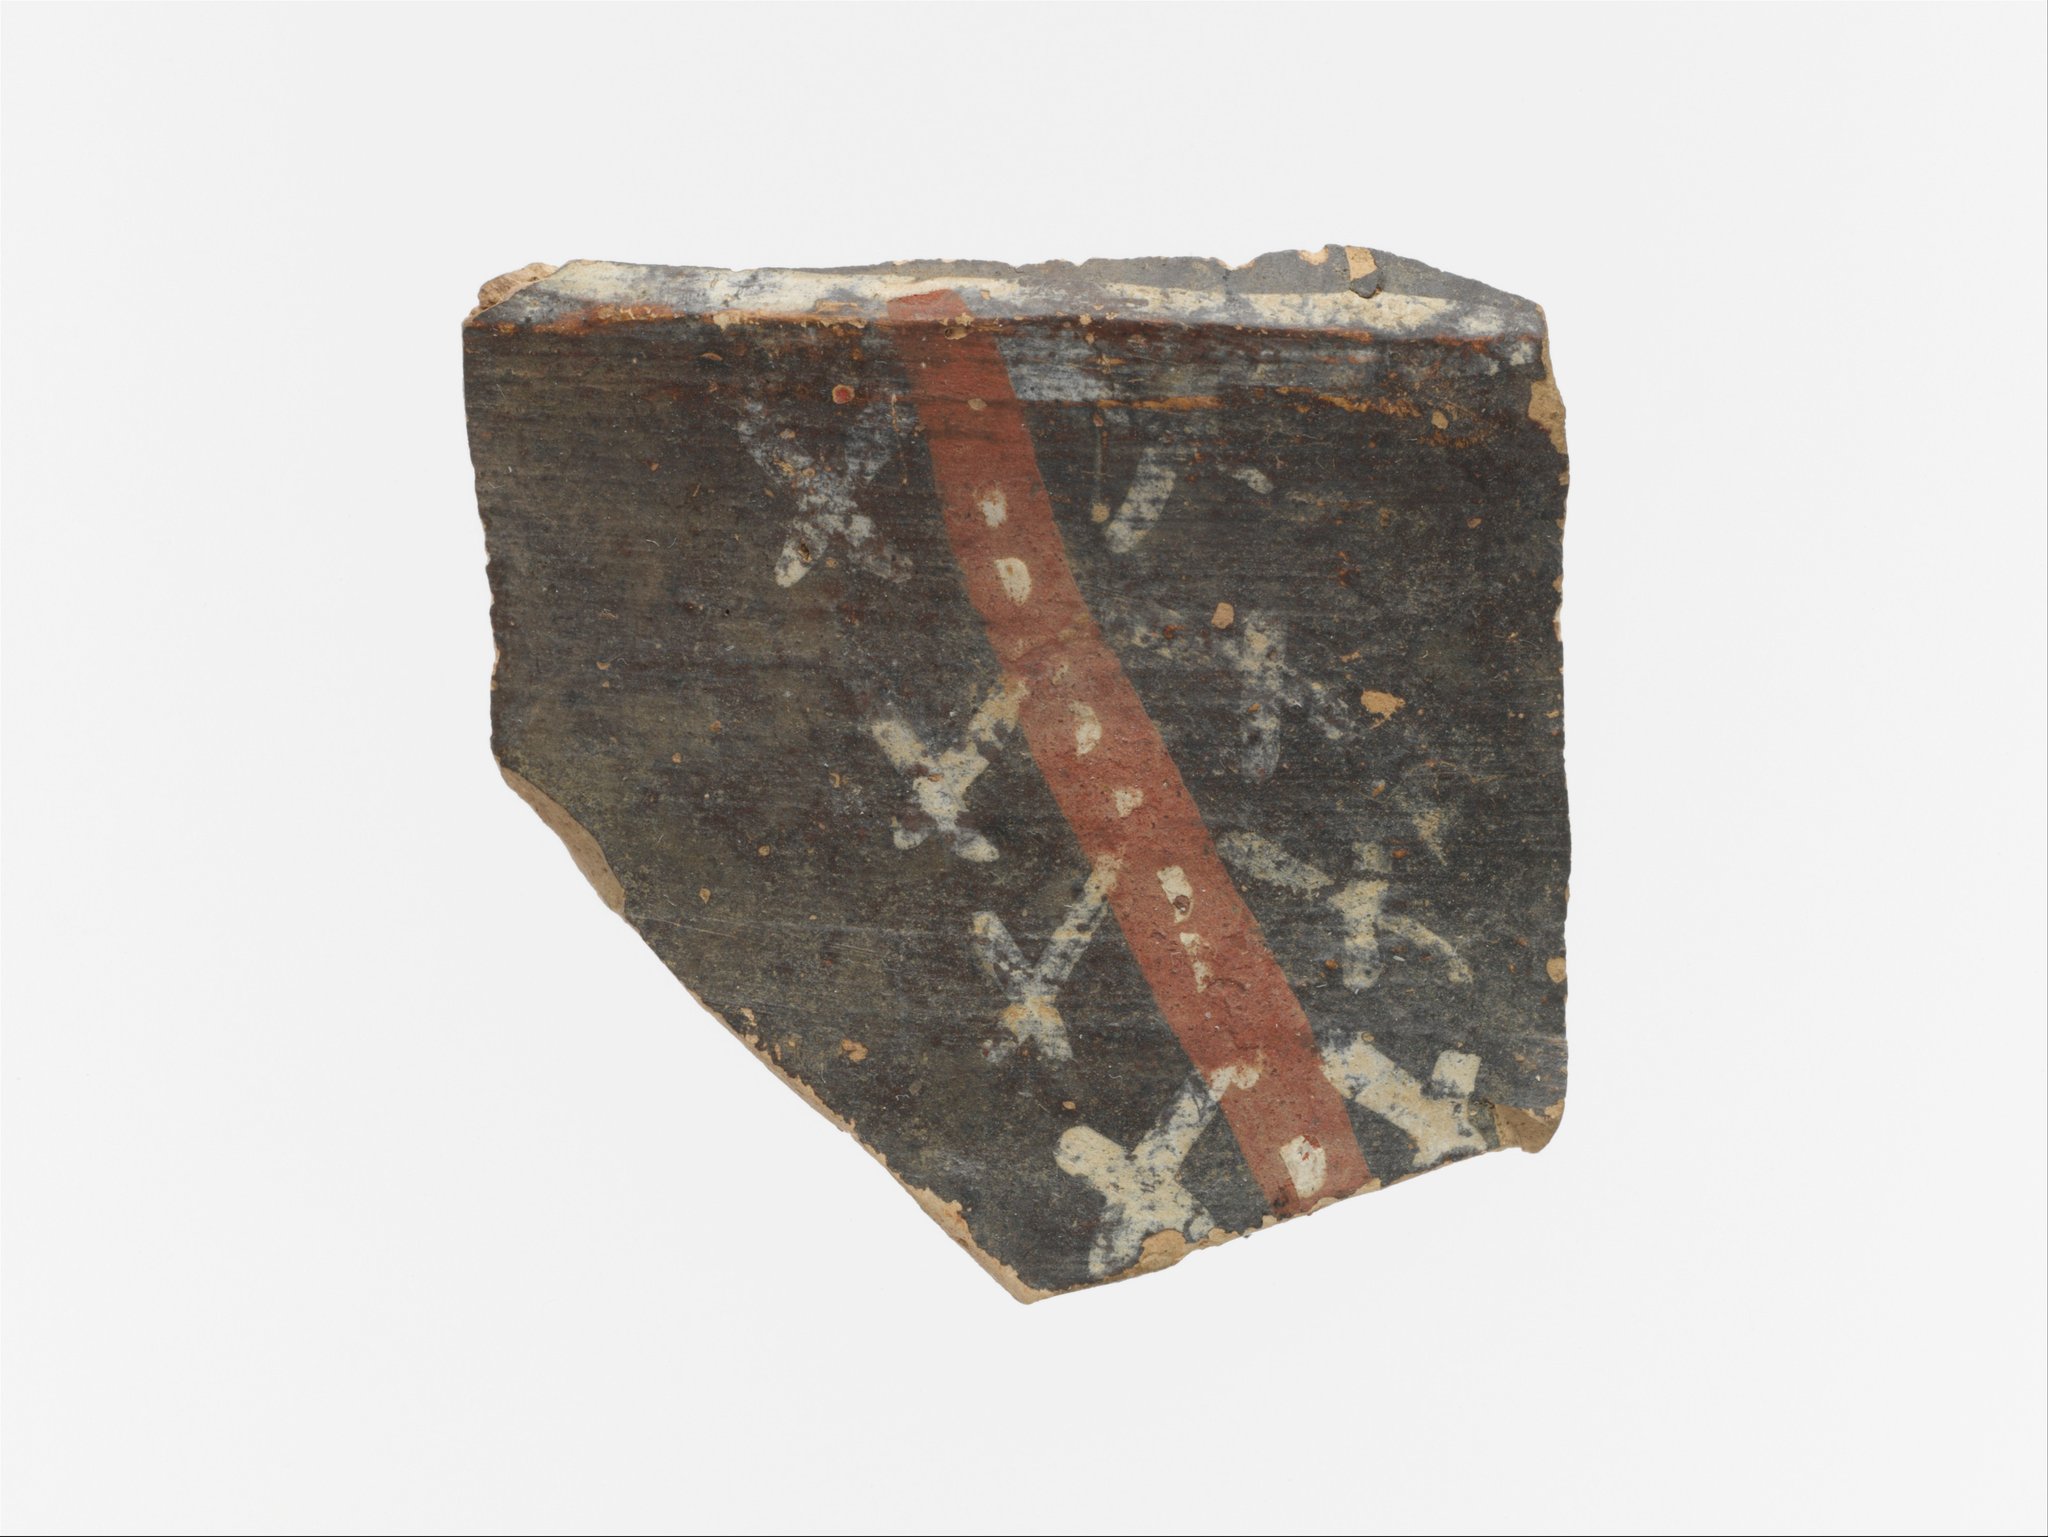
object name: vase fragment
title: Terracotta rim of a cup with polychrome motifs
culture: minoan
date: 1800-1700 BCE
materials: terracotta